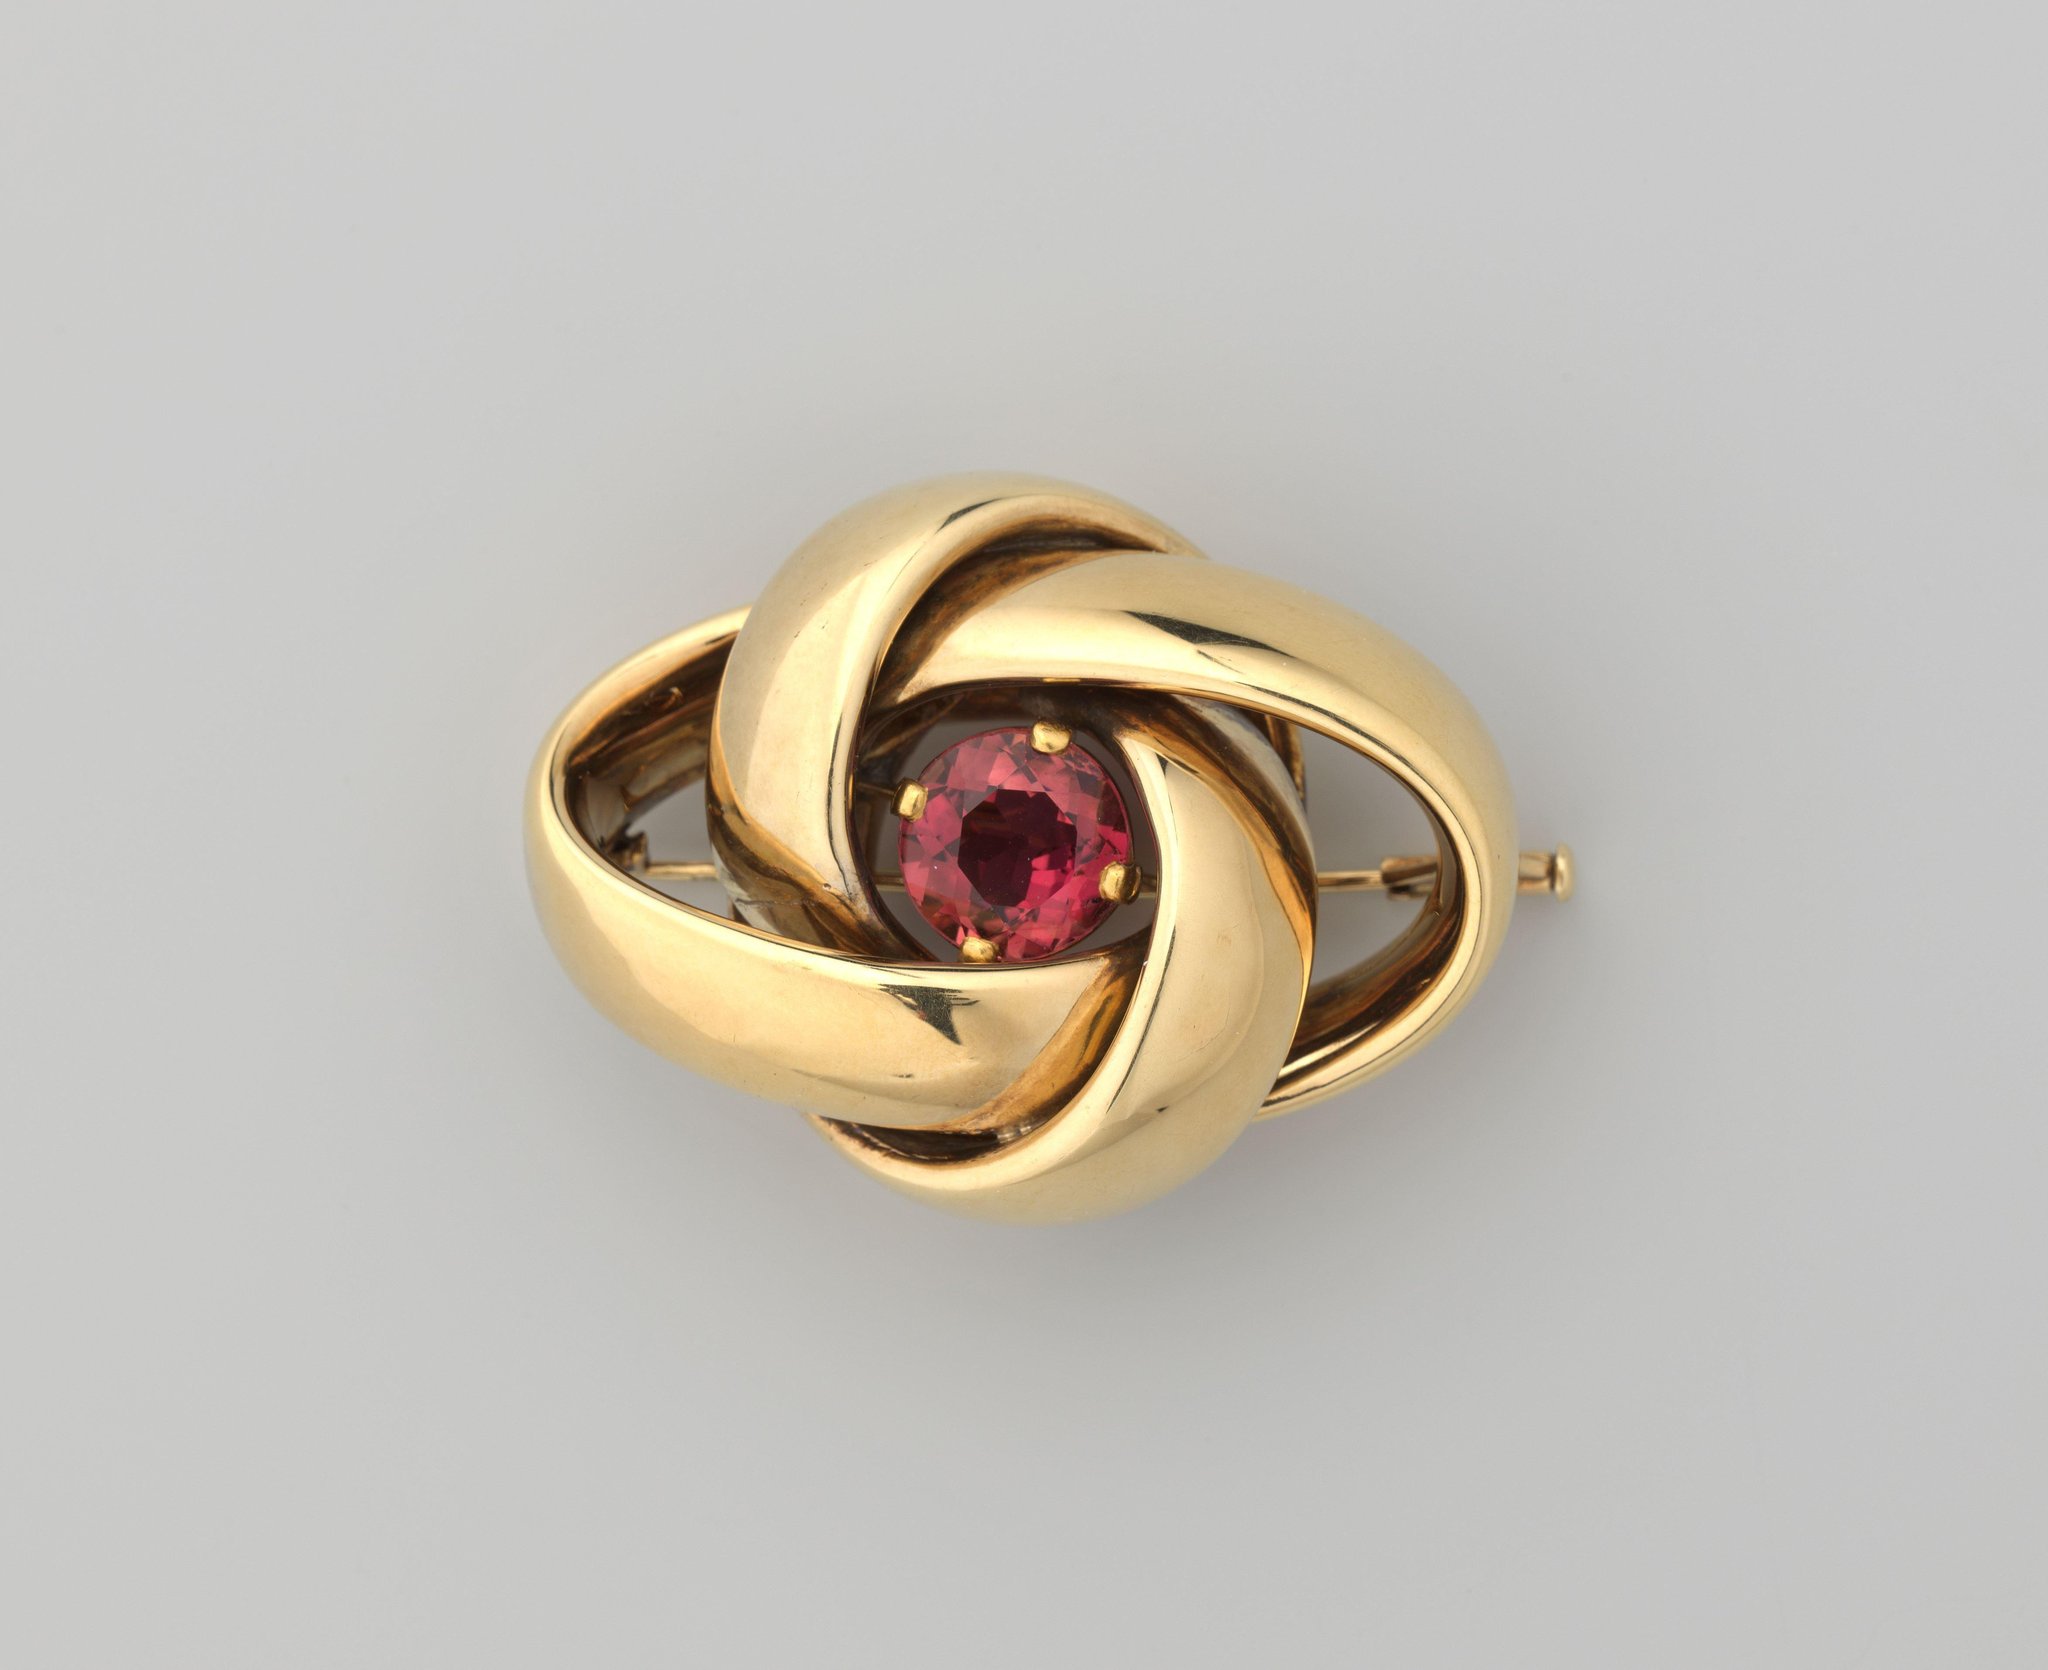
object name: brooch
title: Gevlochten broche van goud met roze toermalijn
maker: Anonymous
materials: gold, gemstone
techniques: braiding, faceting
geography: netherlands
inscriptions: maker's mark, alloy mark: ‘oud eikenblad’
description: Gevlochten broche van goud met roze toermalijn voorzien van een kanonsluiting.